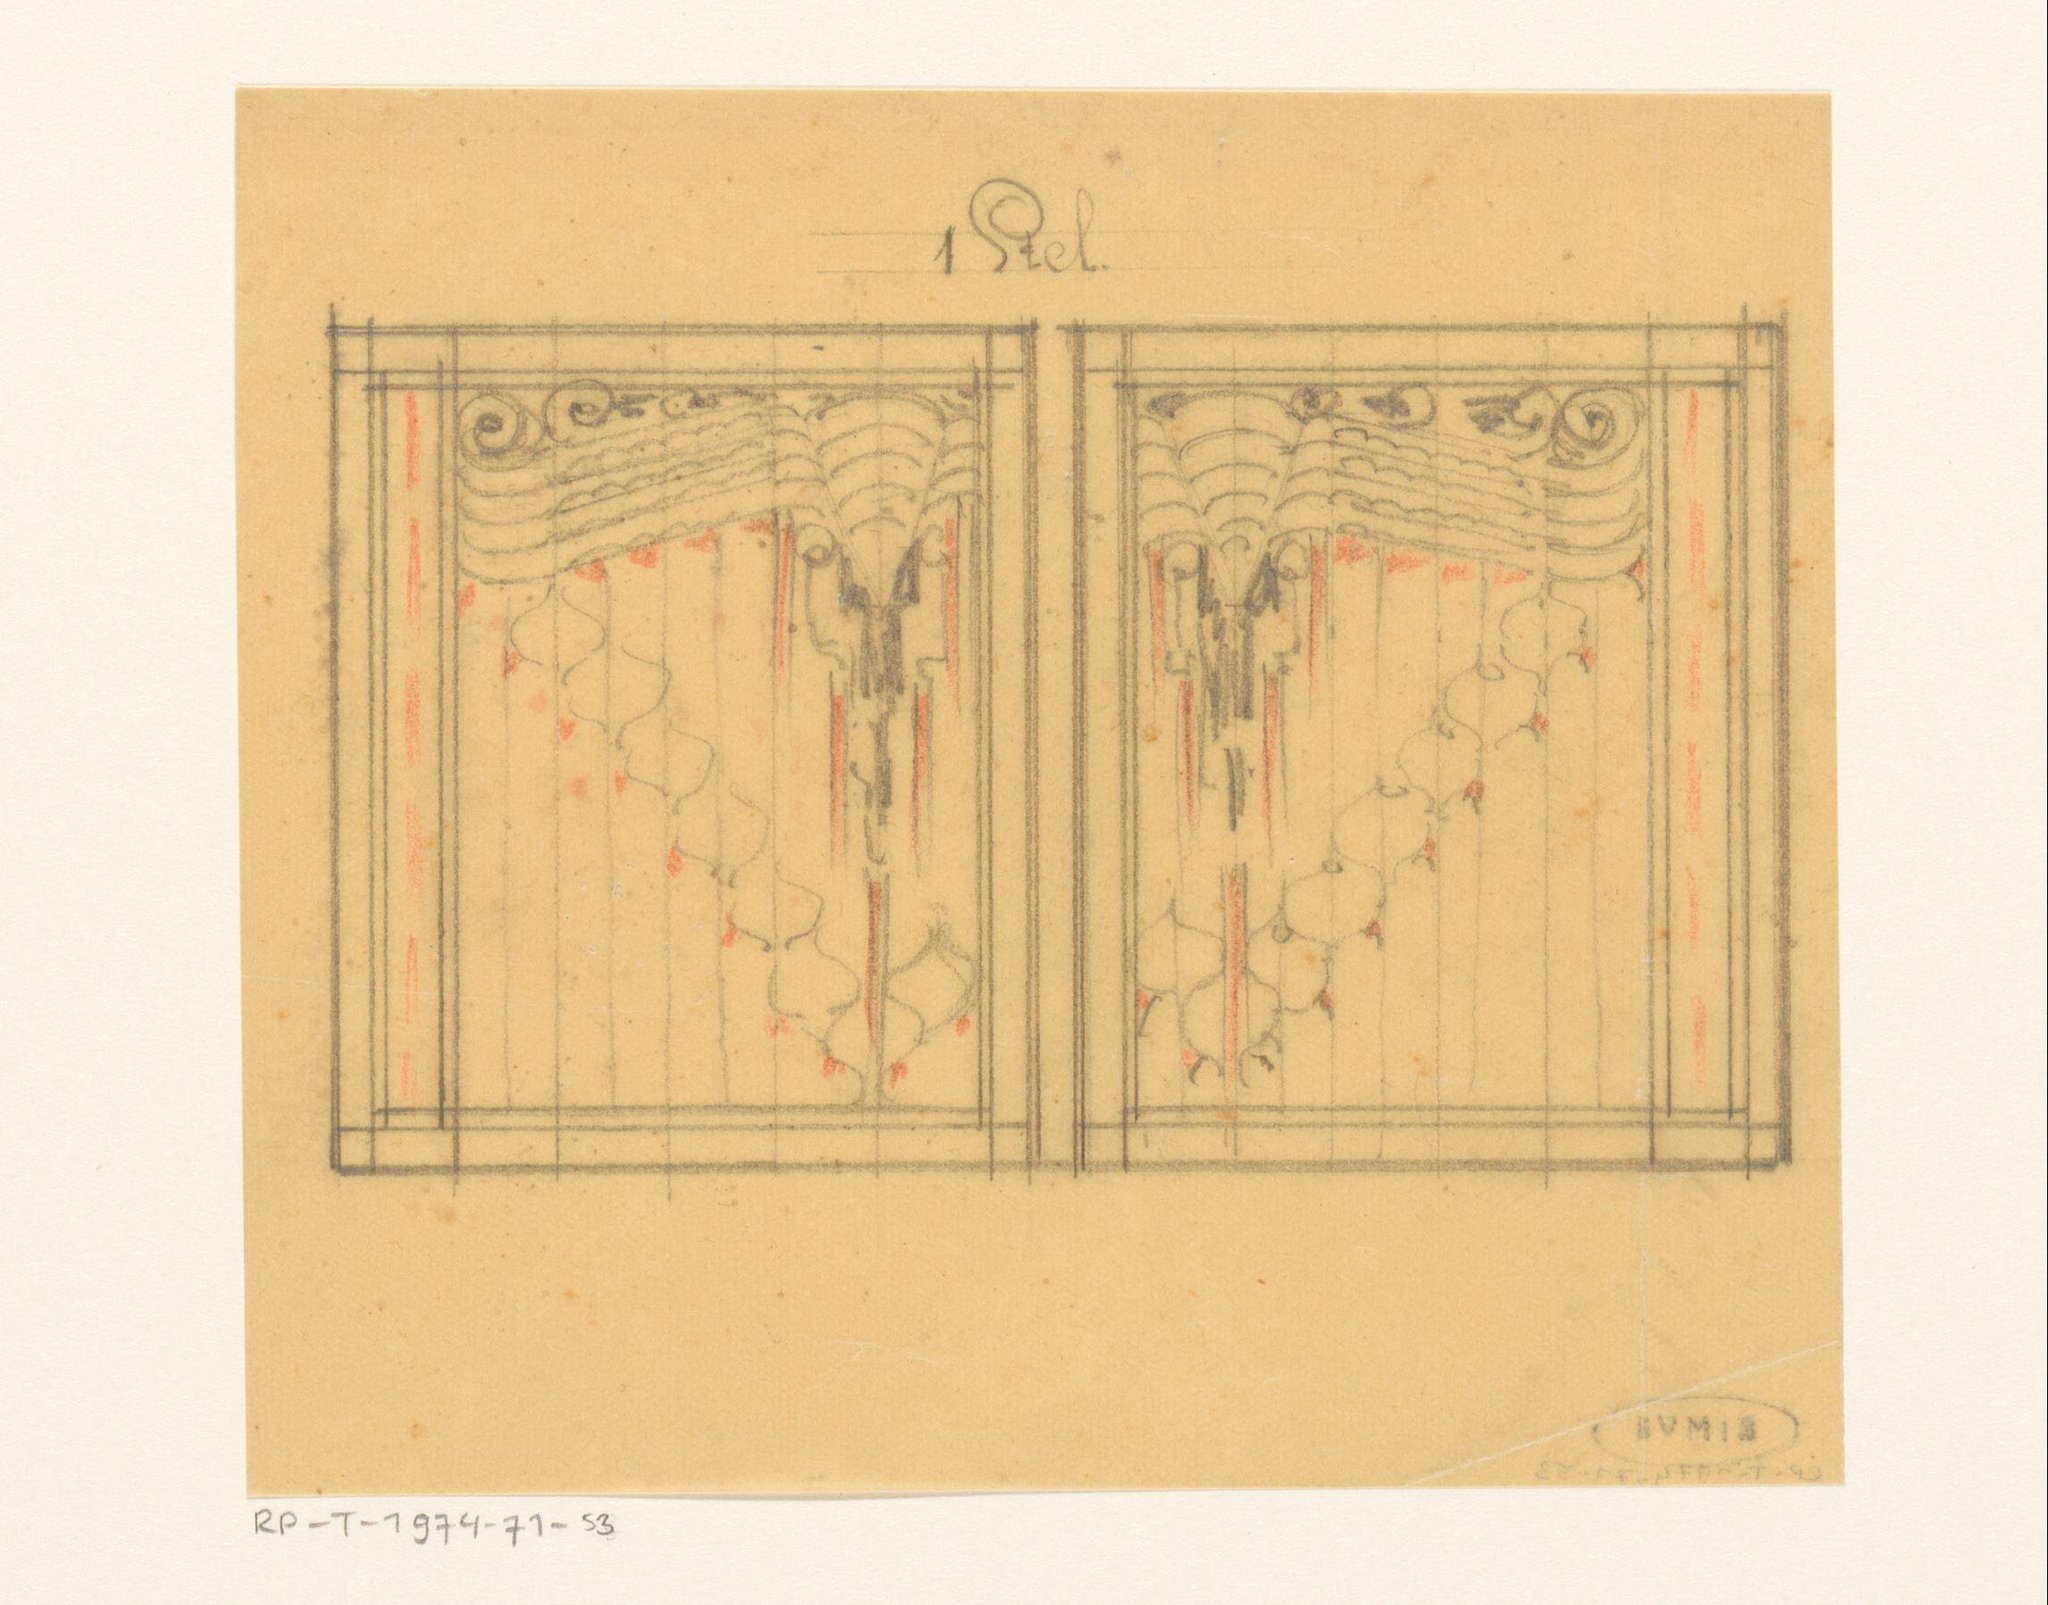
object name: drawing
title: Ontwerp voor twee glas in loodramen met ornamenten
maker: Anonymous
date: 1907-1930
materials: pencil, paper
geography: amsterdam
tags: ornaments ~ art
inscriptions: inscription: ‘1 Stel.’, collector's mark: ‘R:MVS’